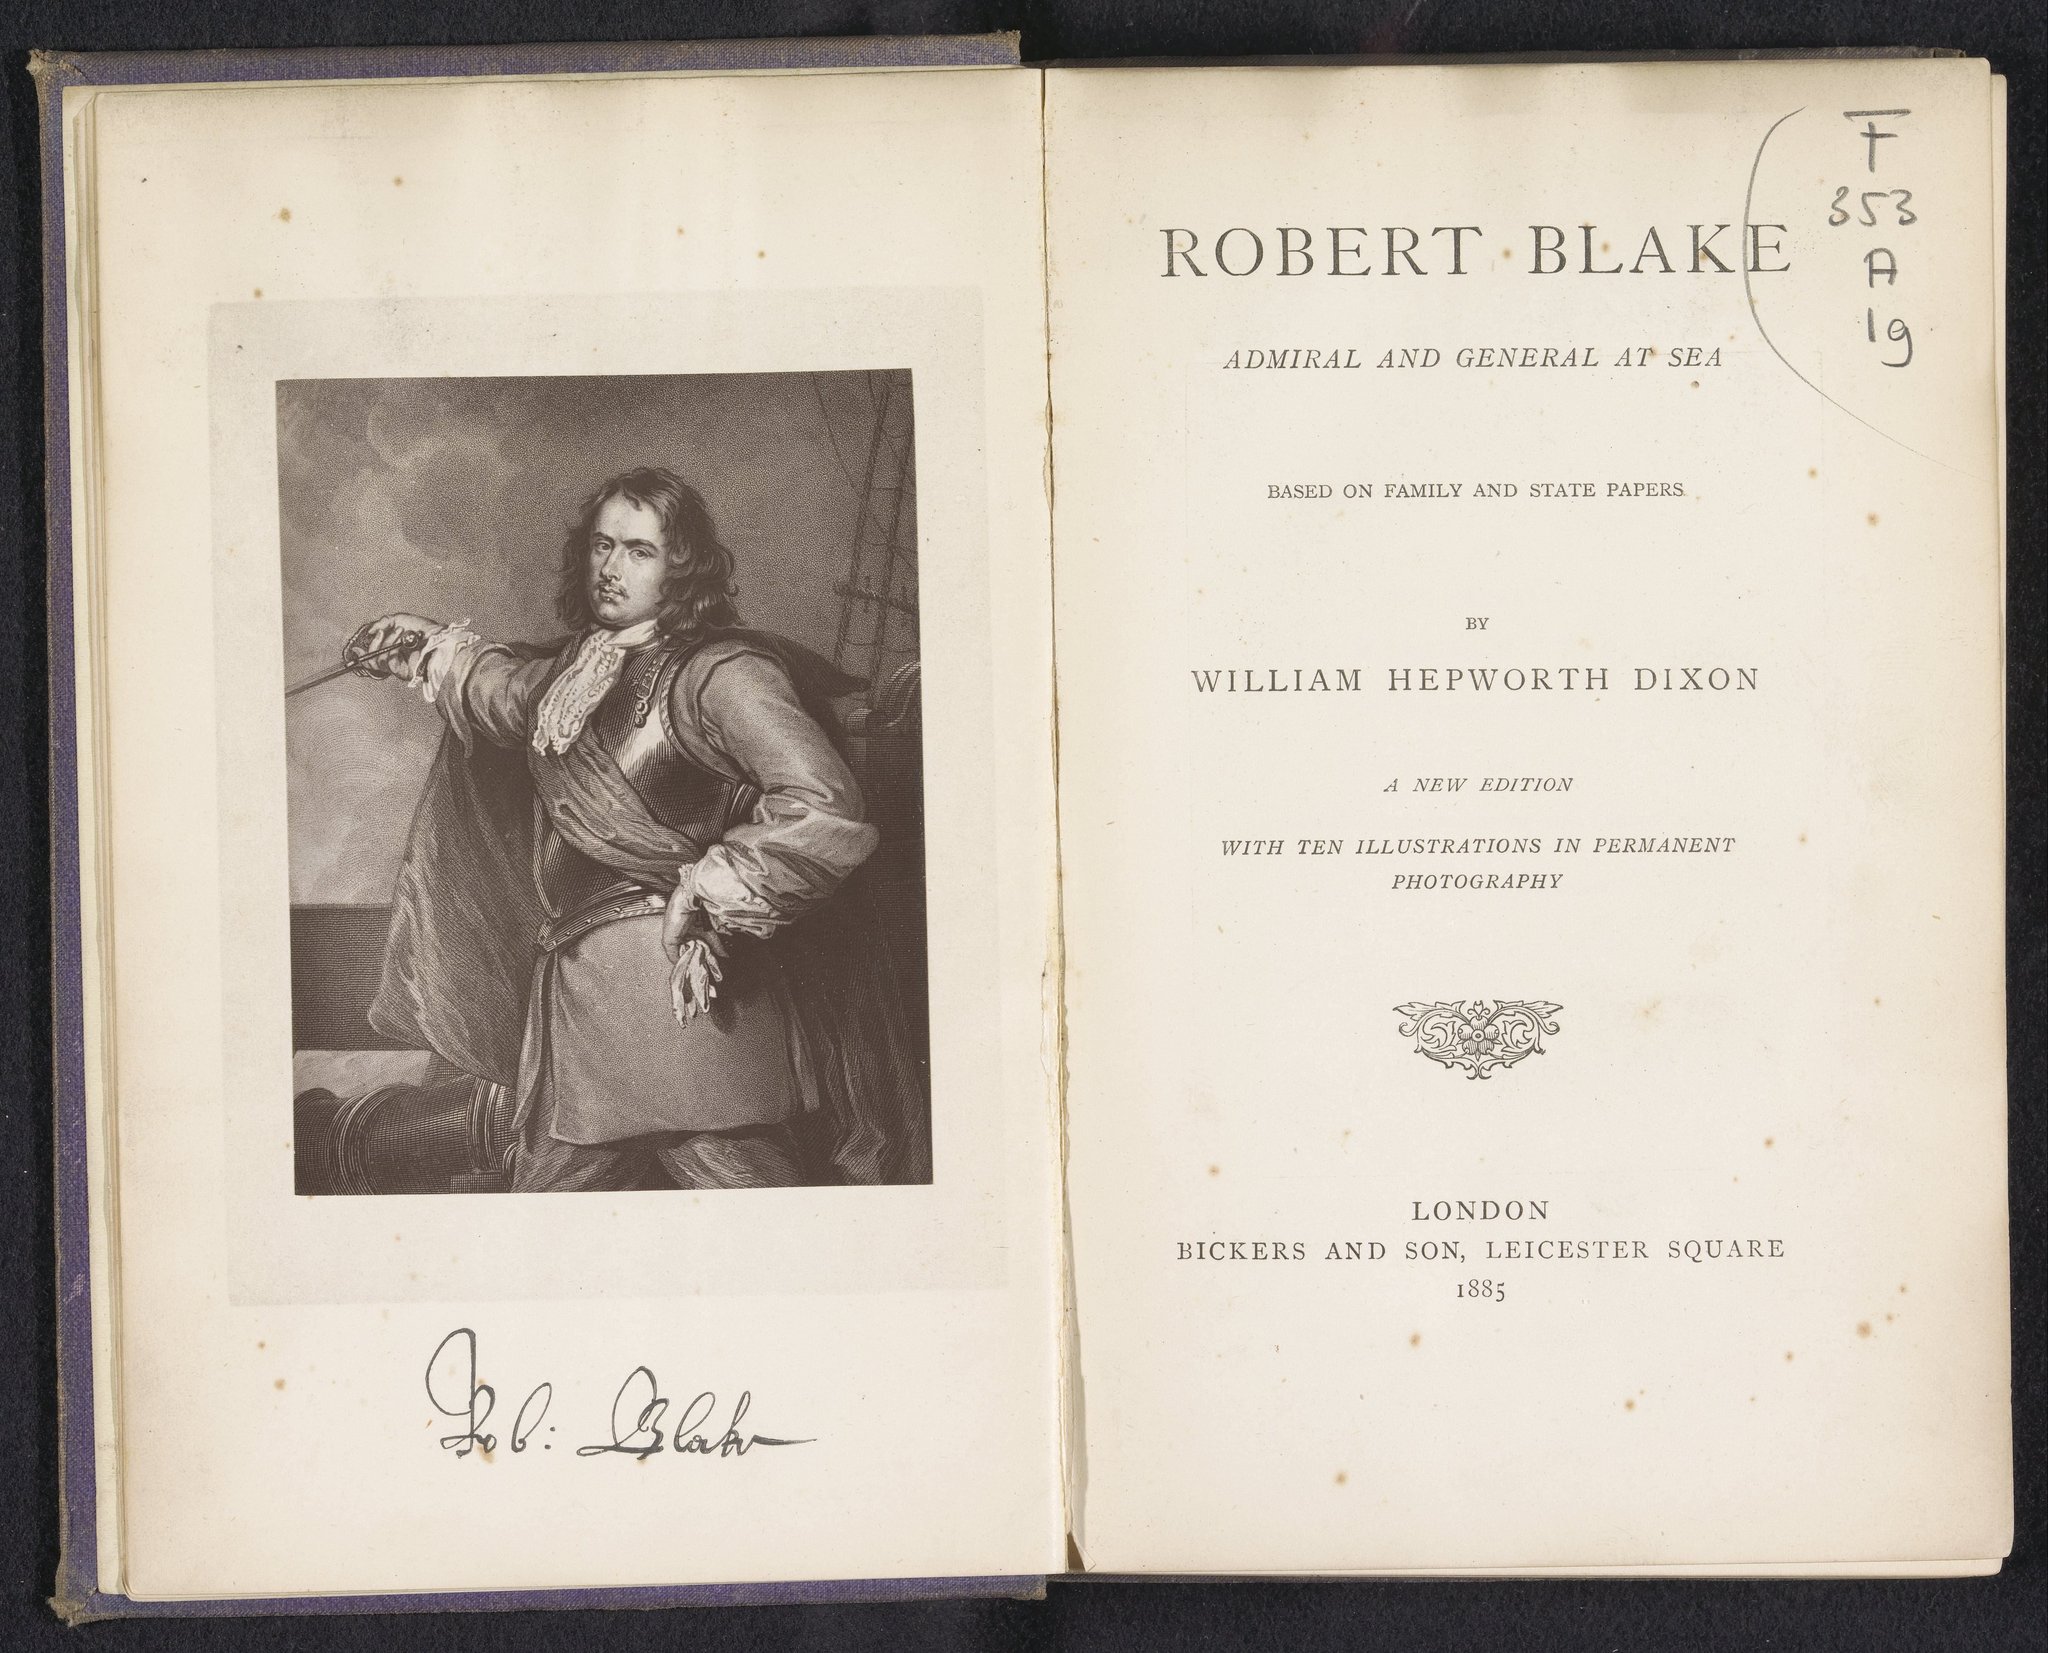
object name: page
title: Fotoreproductie van een prent, voorstellende een portret van Robert Blake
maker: Anonymous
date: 1875-1885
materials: paper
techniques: woodburytype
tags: commander-in-chief, admiral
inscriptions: name: ‘Rob: Blake’